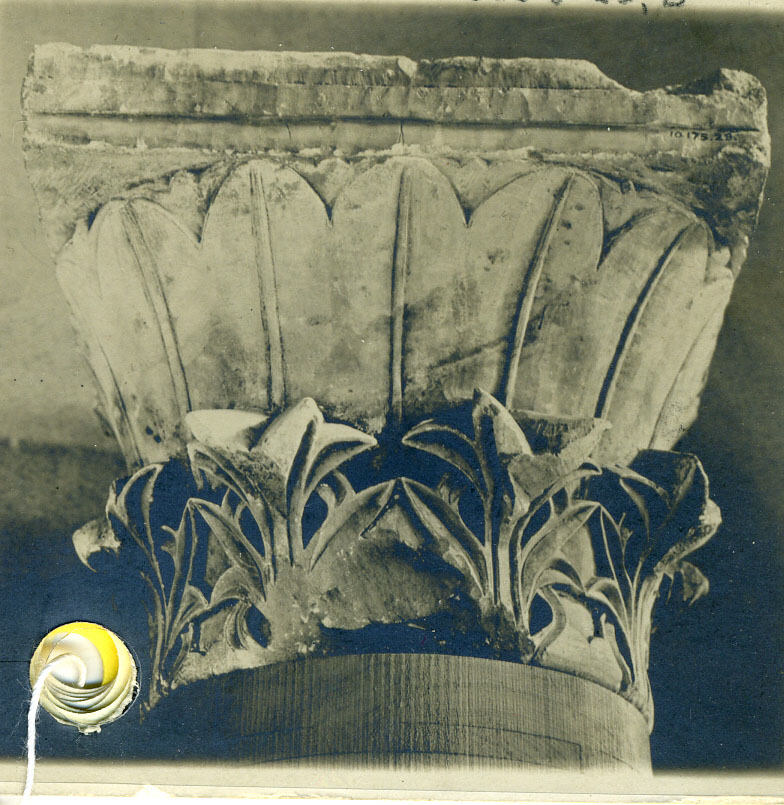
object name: capital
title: Capital with Acanthus and Palm Leaves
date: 501-600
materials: limestone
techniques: carving, relief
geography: egypt